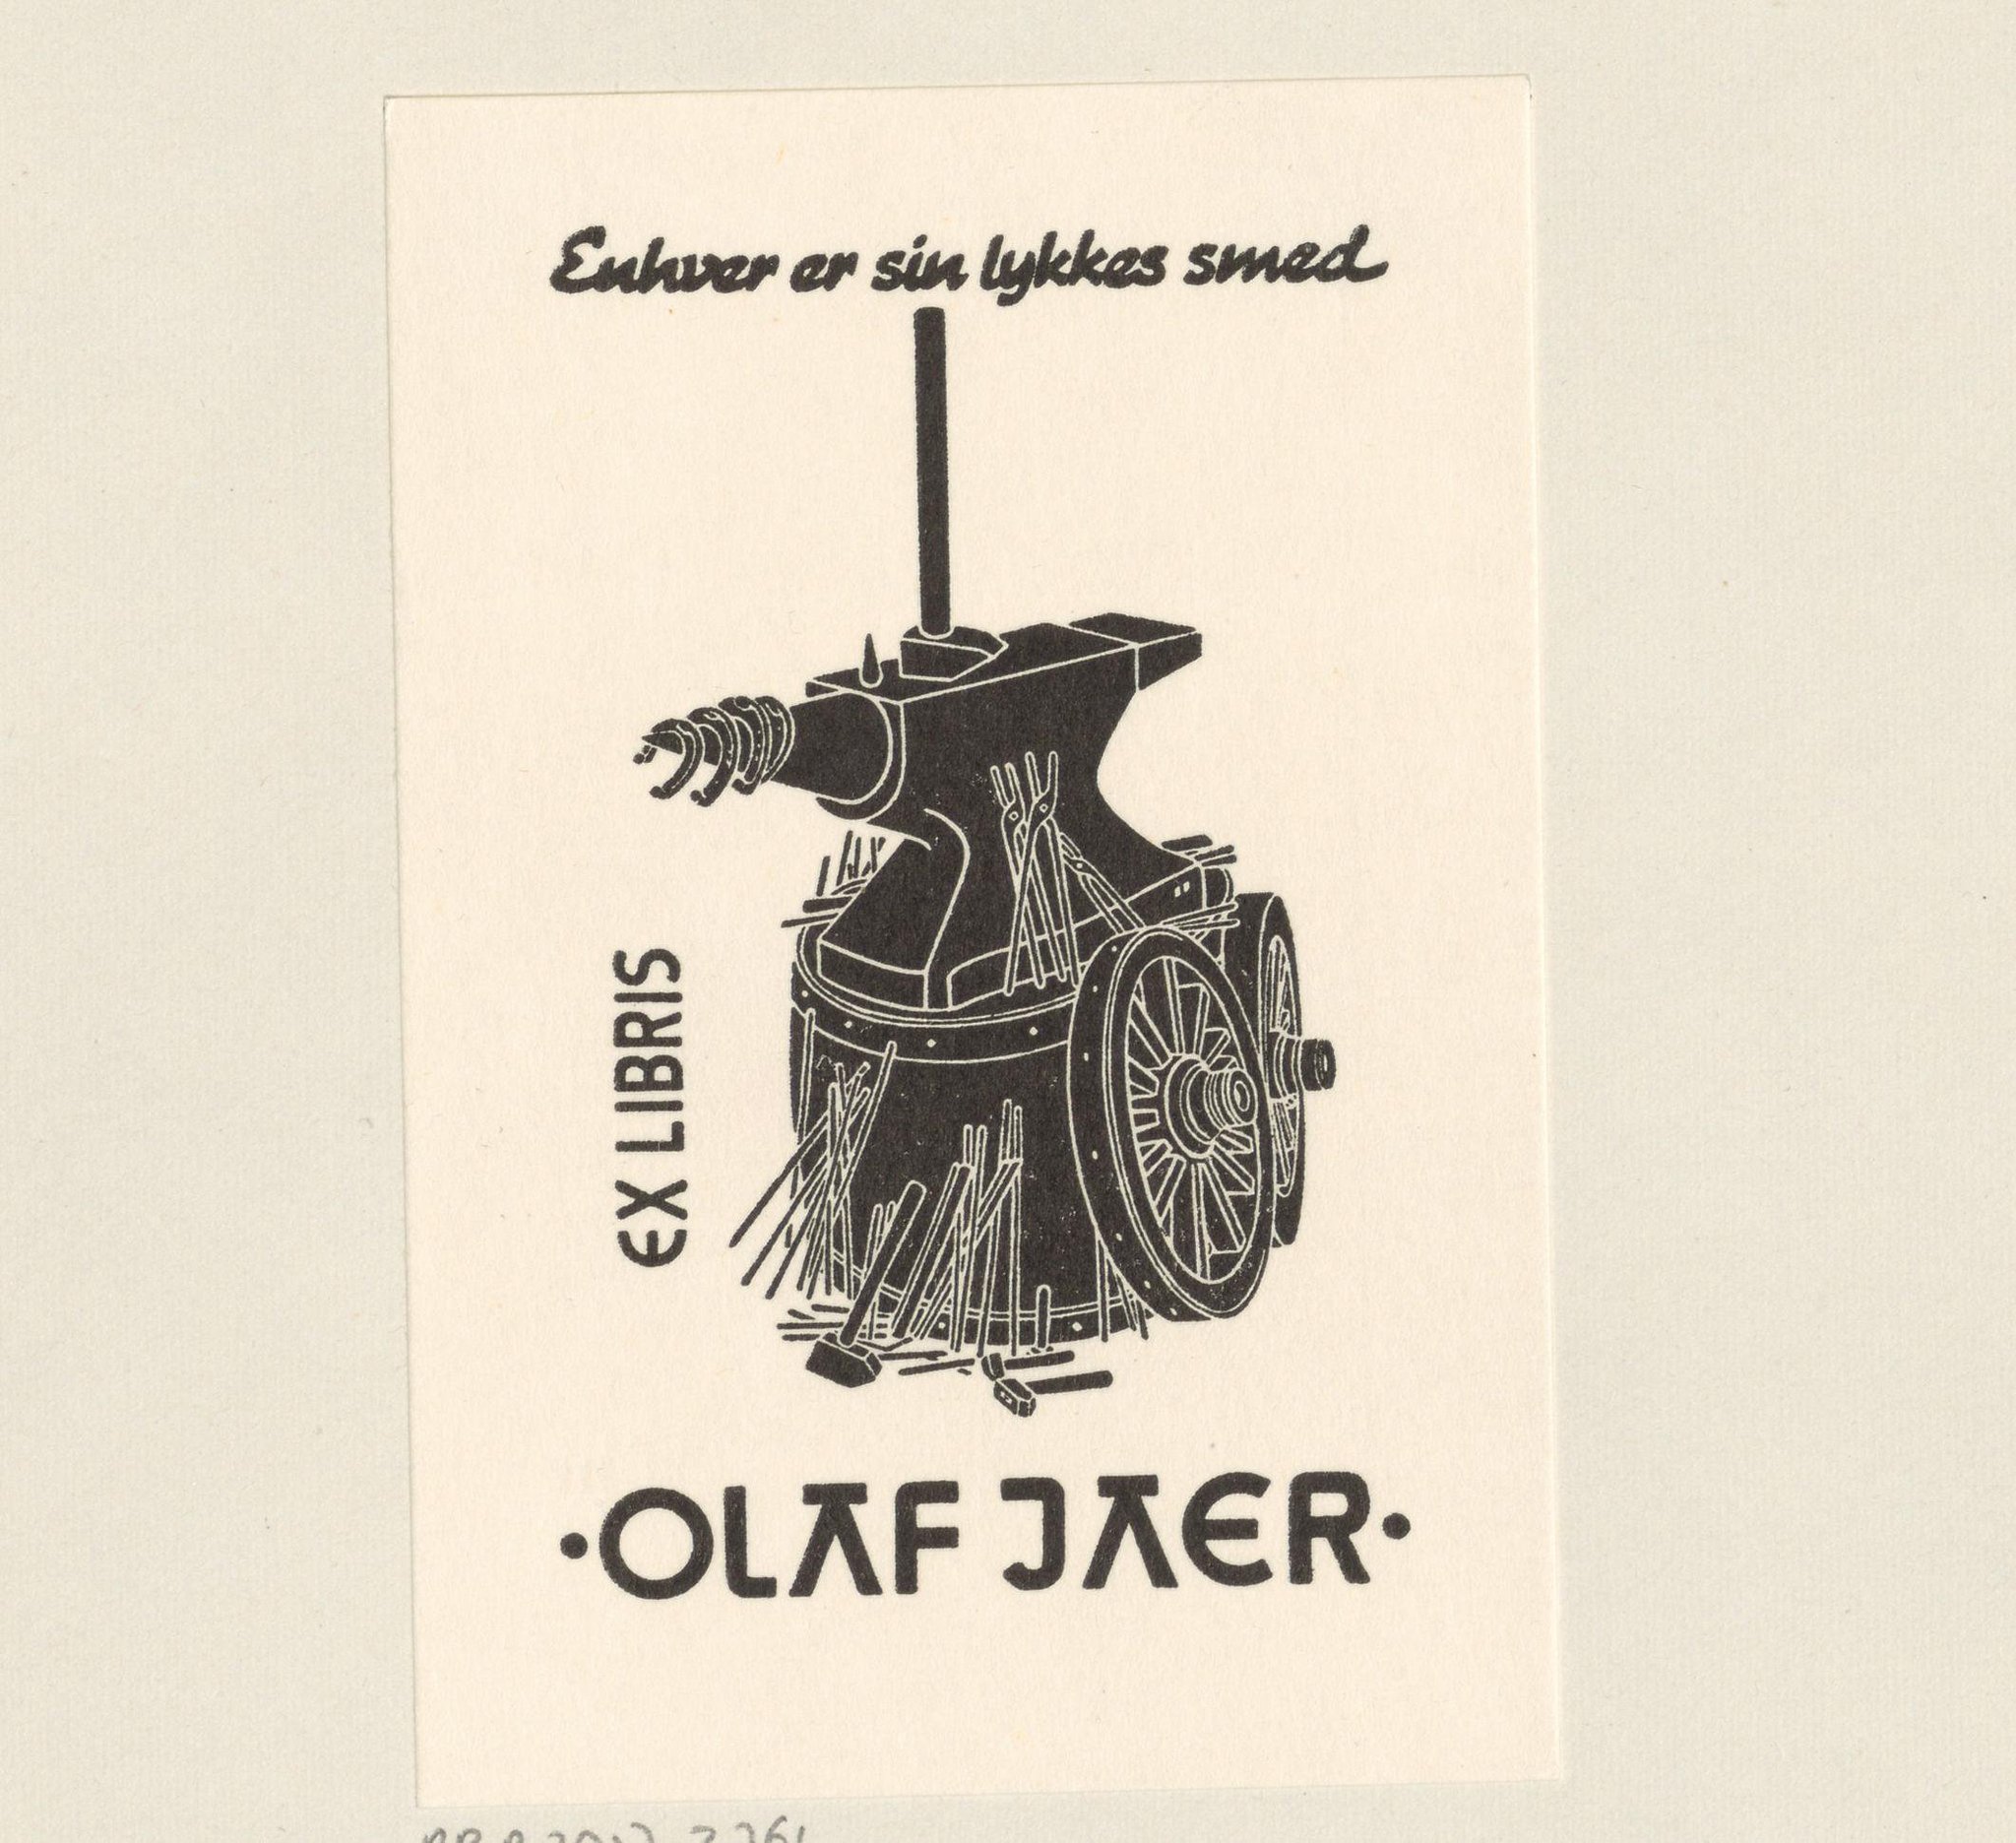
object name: bookplate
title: Enhver er sin lykkes smed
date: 1940-1950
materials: paper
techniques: printing block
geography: norway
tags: olaf jaer, wheel (of vehicle), horseshoe, tools, aids, implements ~ crafts and industries: anvil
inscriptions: workshop stamp: ‘Olaf Jaer’